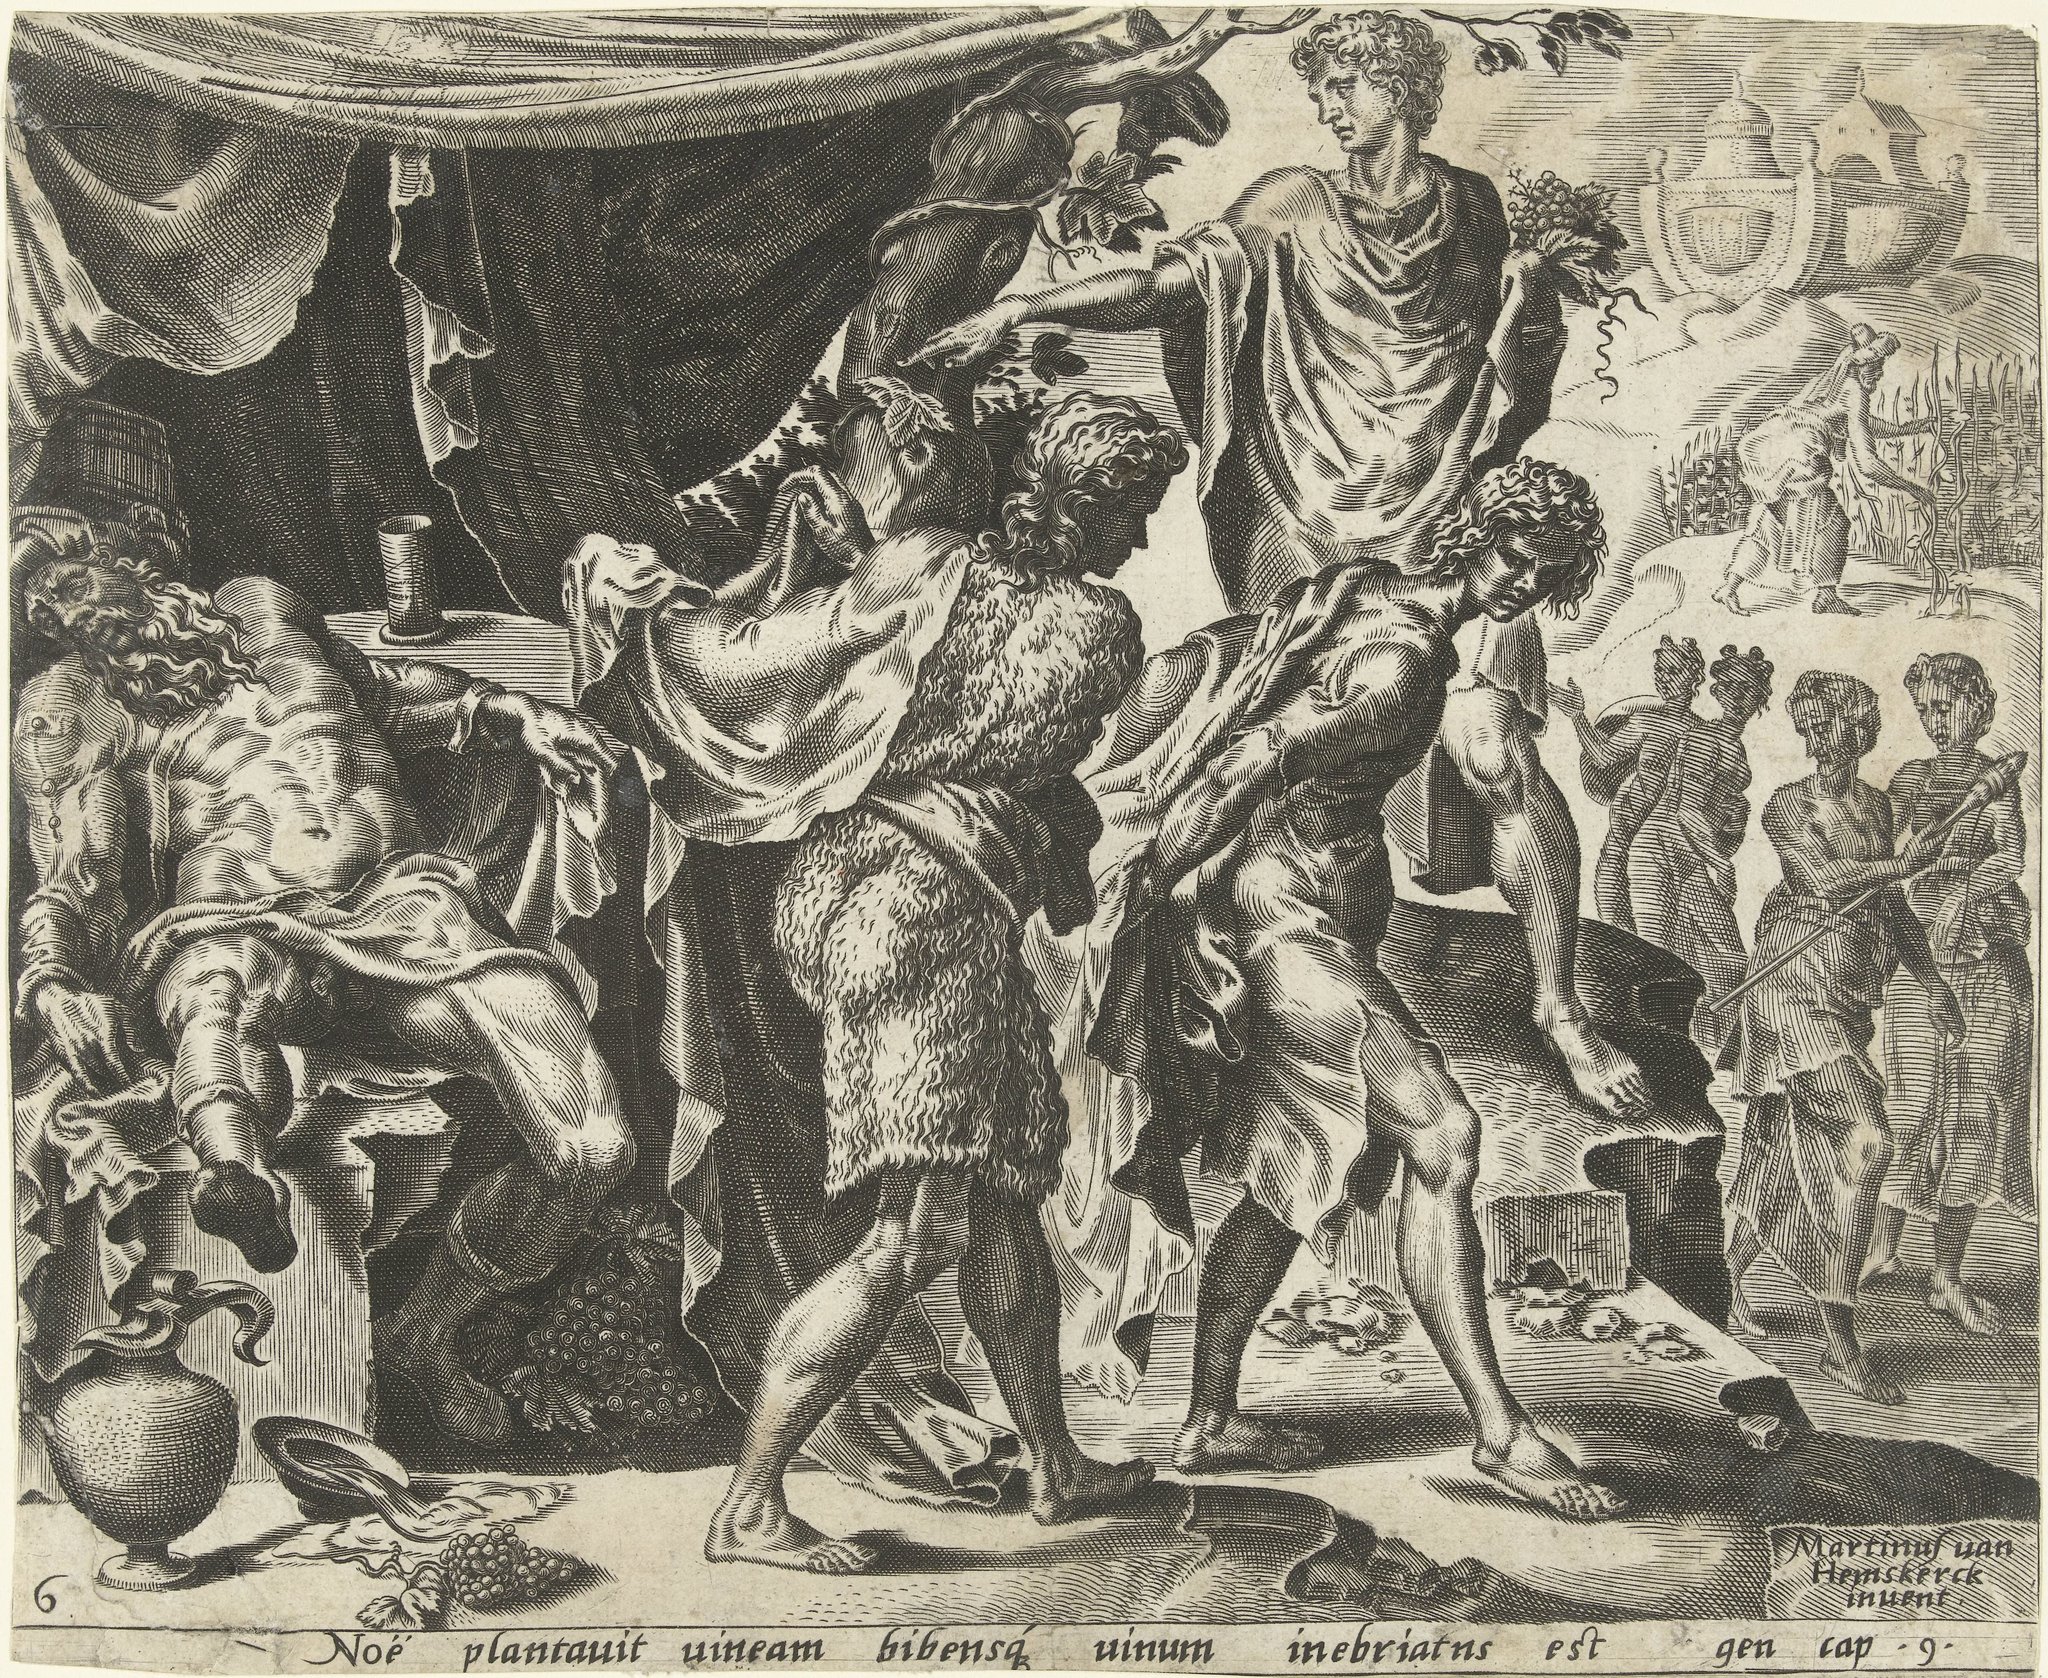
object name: print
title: Dronkenschap van Noach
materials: paper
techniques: engraving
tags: shem and japheth walking backwards towards noah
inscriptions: signature: ‘Martinus van / Hemskerck / invent.’, collector's mark: Lugt 2228, number: ‘6’, caption: ‘Noë plantavit vineam bibensq[ue] inebriatus est gen cap. 9’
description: Noach ligt dronken en half ontkleed in zijn tent. Op de grond een wijnkruik en op de tafel naast hem een wijnbeker. Zijn zoon Cham wijst naar hem en bespot hem. Sem en Jafet schermen hun vader af met een kleed. Rechts achter is Noach te zien hoe hij zijn wijngaard bewerkt, op een heuvel staat de ark.